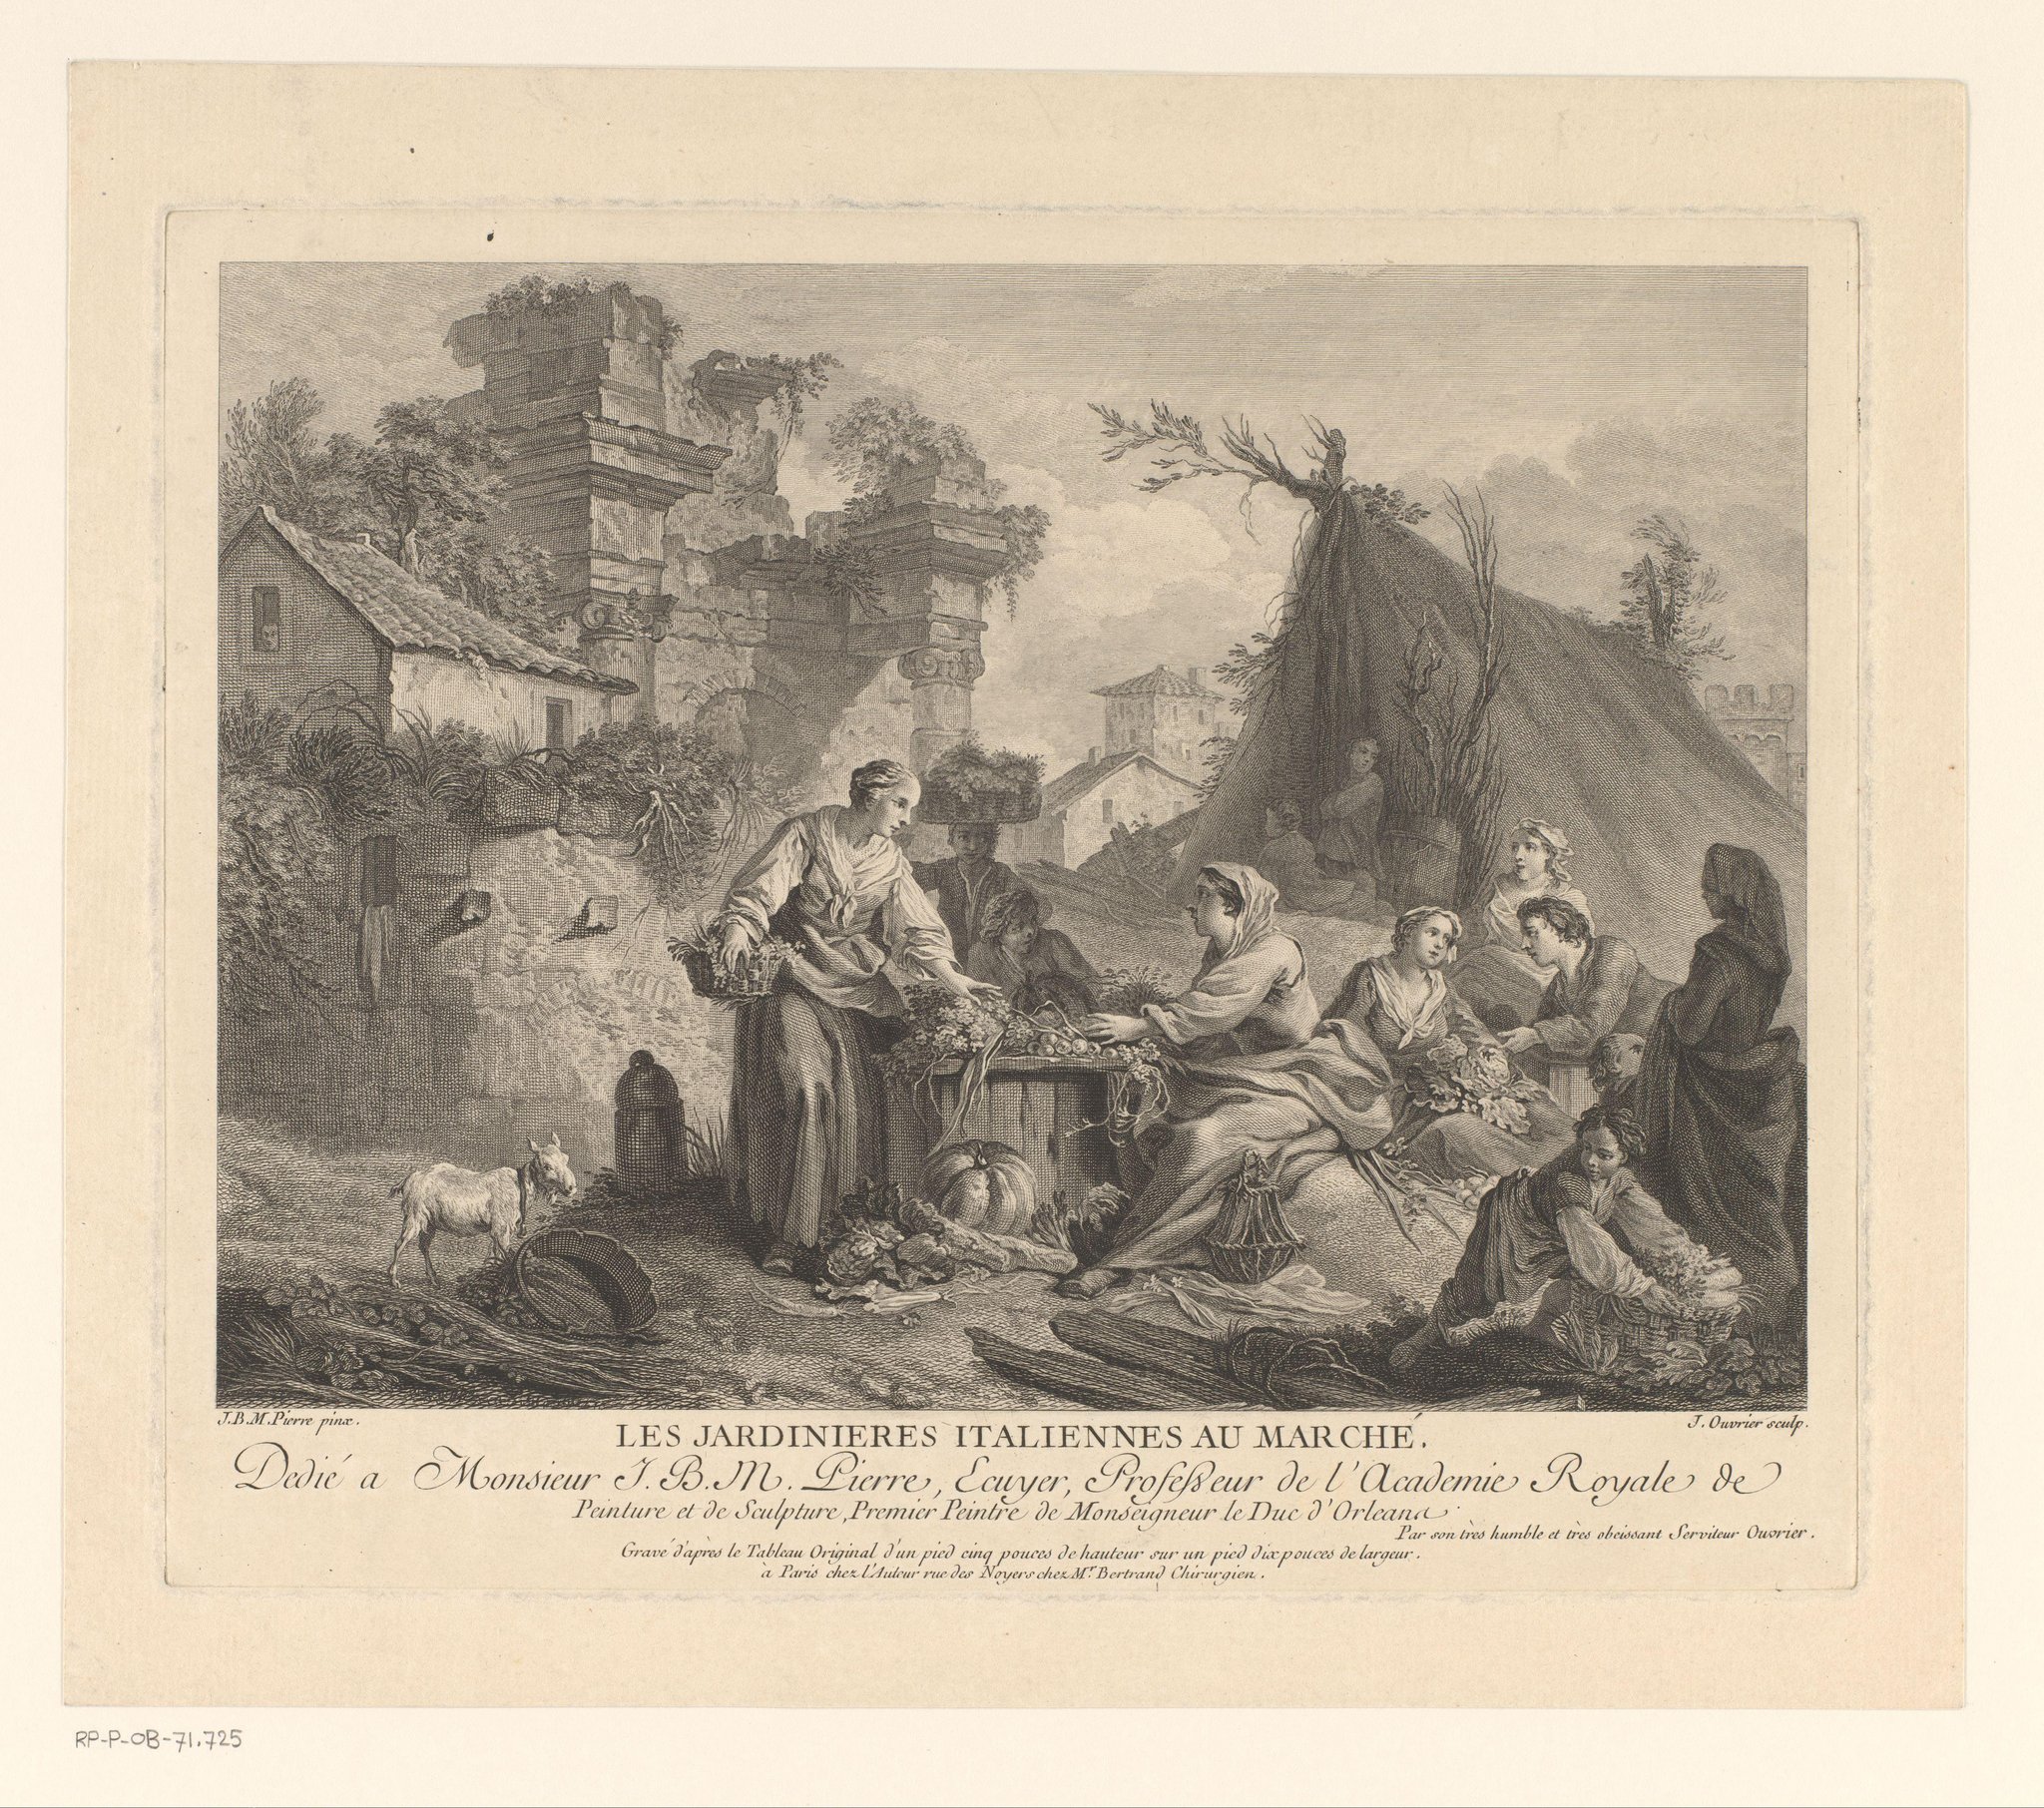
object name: print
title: Les Jardinieres Italiennes au Marché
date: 1735-1784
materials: paper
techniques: engraving, etching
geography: paris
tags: vegetables, landscape with ruins, market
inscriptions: collector's mark: Lugt 2228